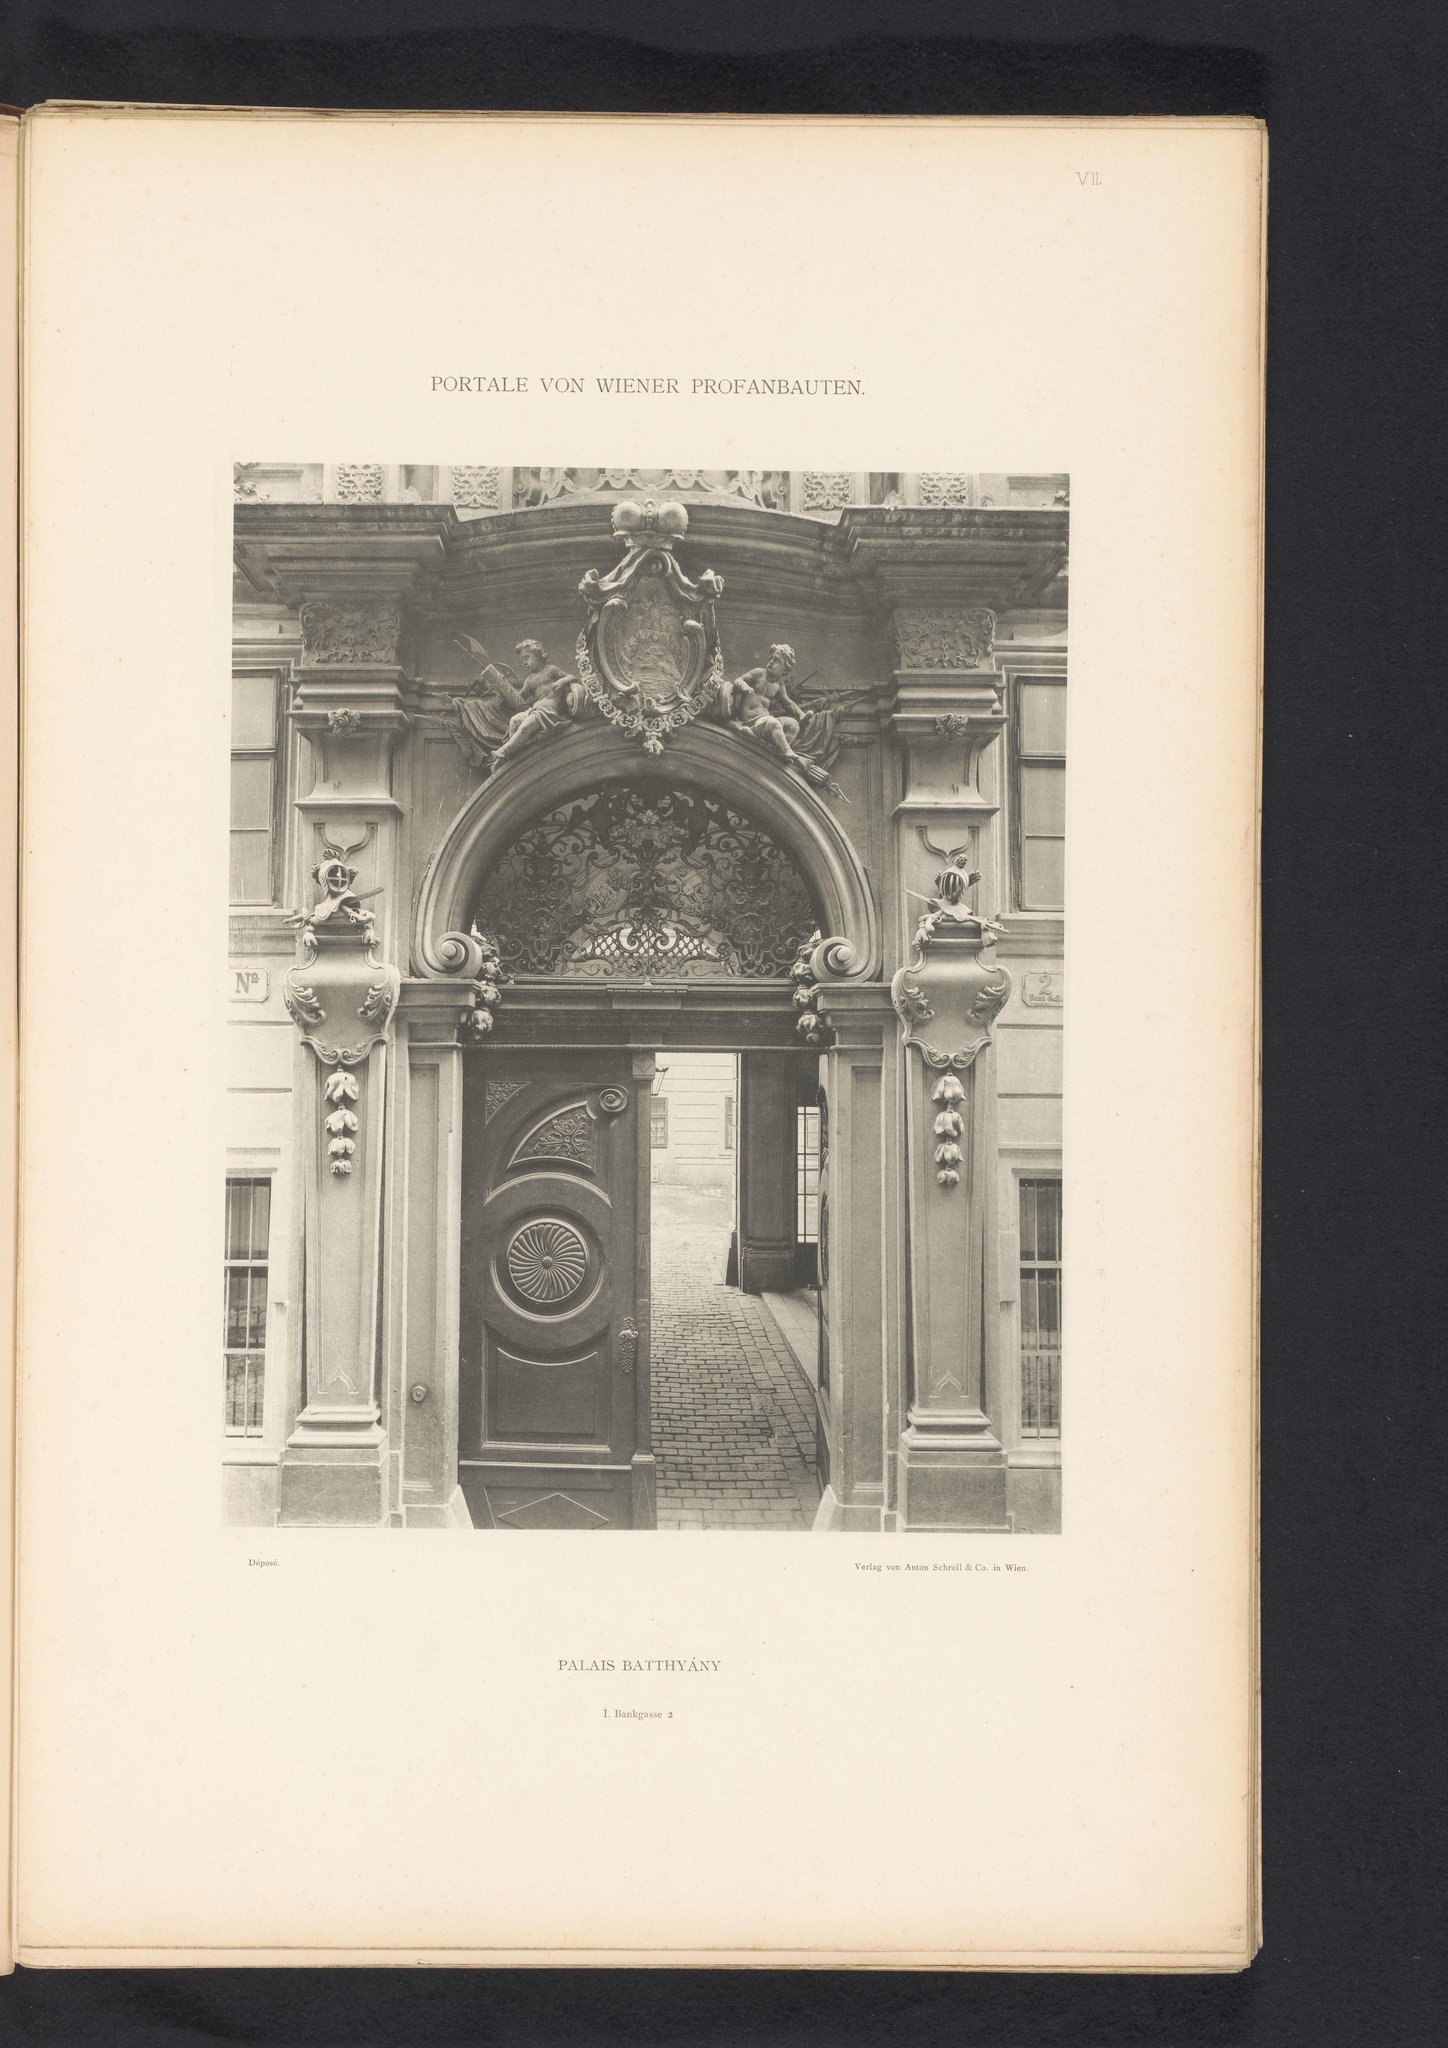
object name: photomechanical print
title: Toegangsportaal van Palais Batthyány te Wenen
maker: Anonymous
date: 1884-1894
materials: paper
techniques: photograph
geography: vienna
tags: gate, entrance, façade (of house or building)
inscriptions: inscription: ‘I. Bankgasse 2’, number: ‘VII.’